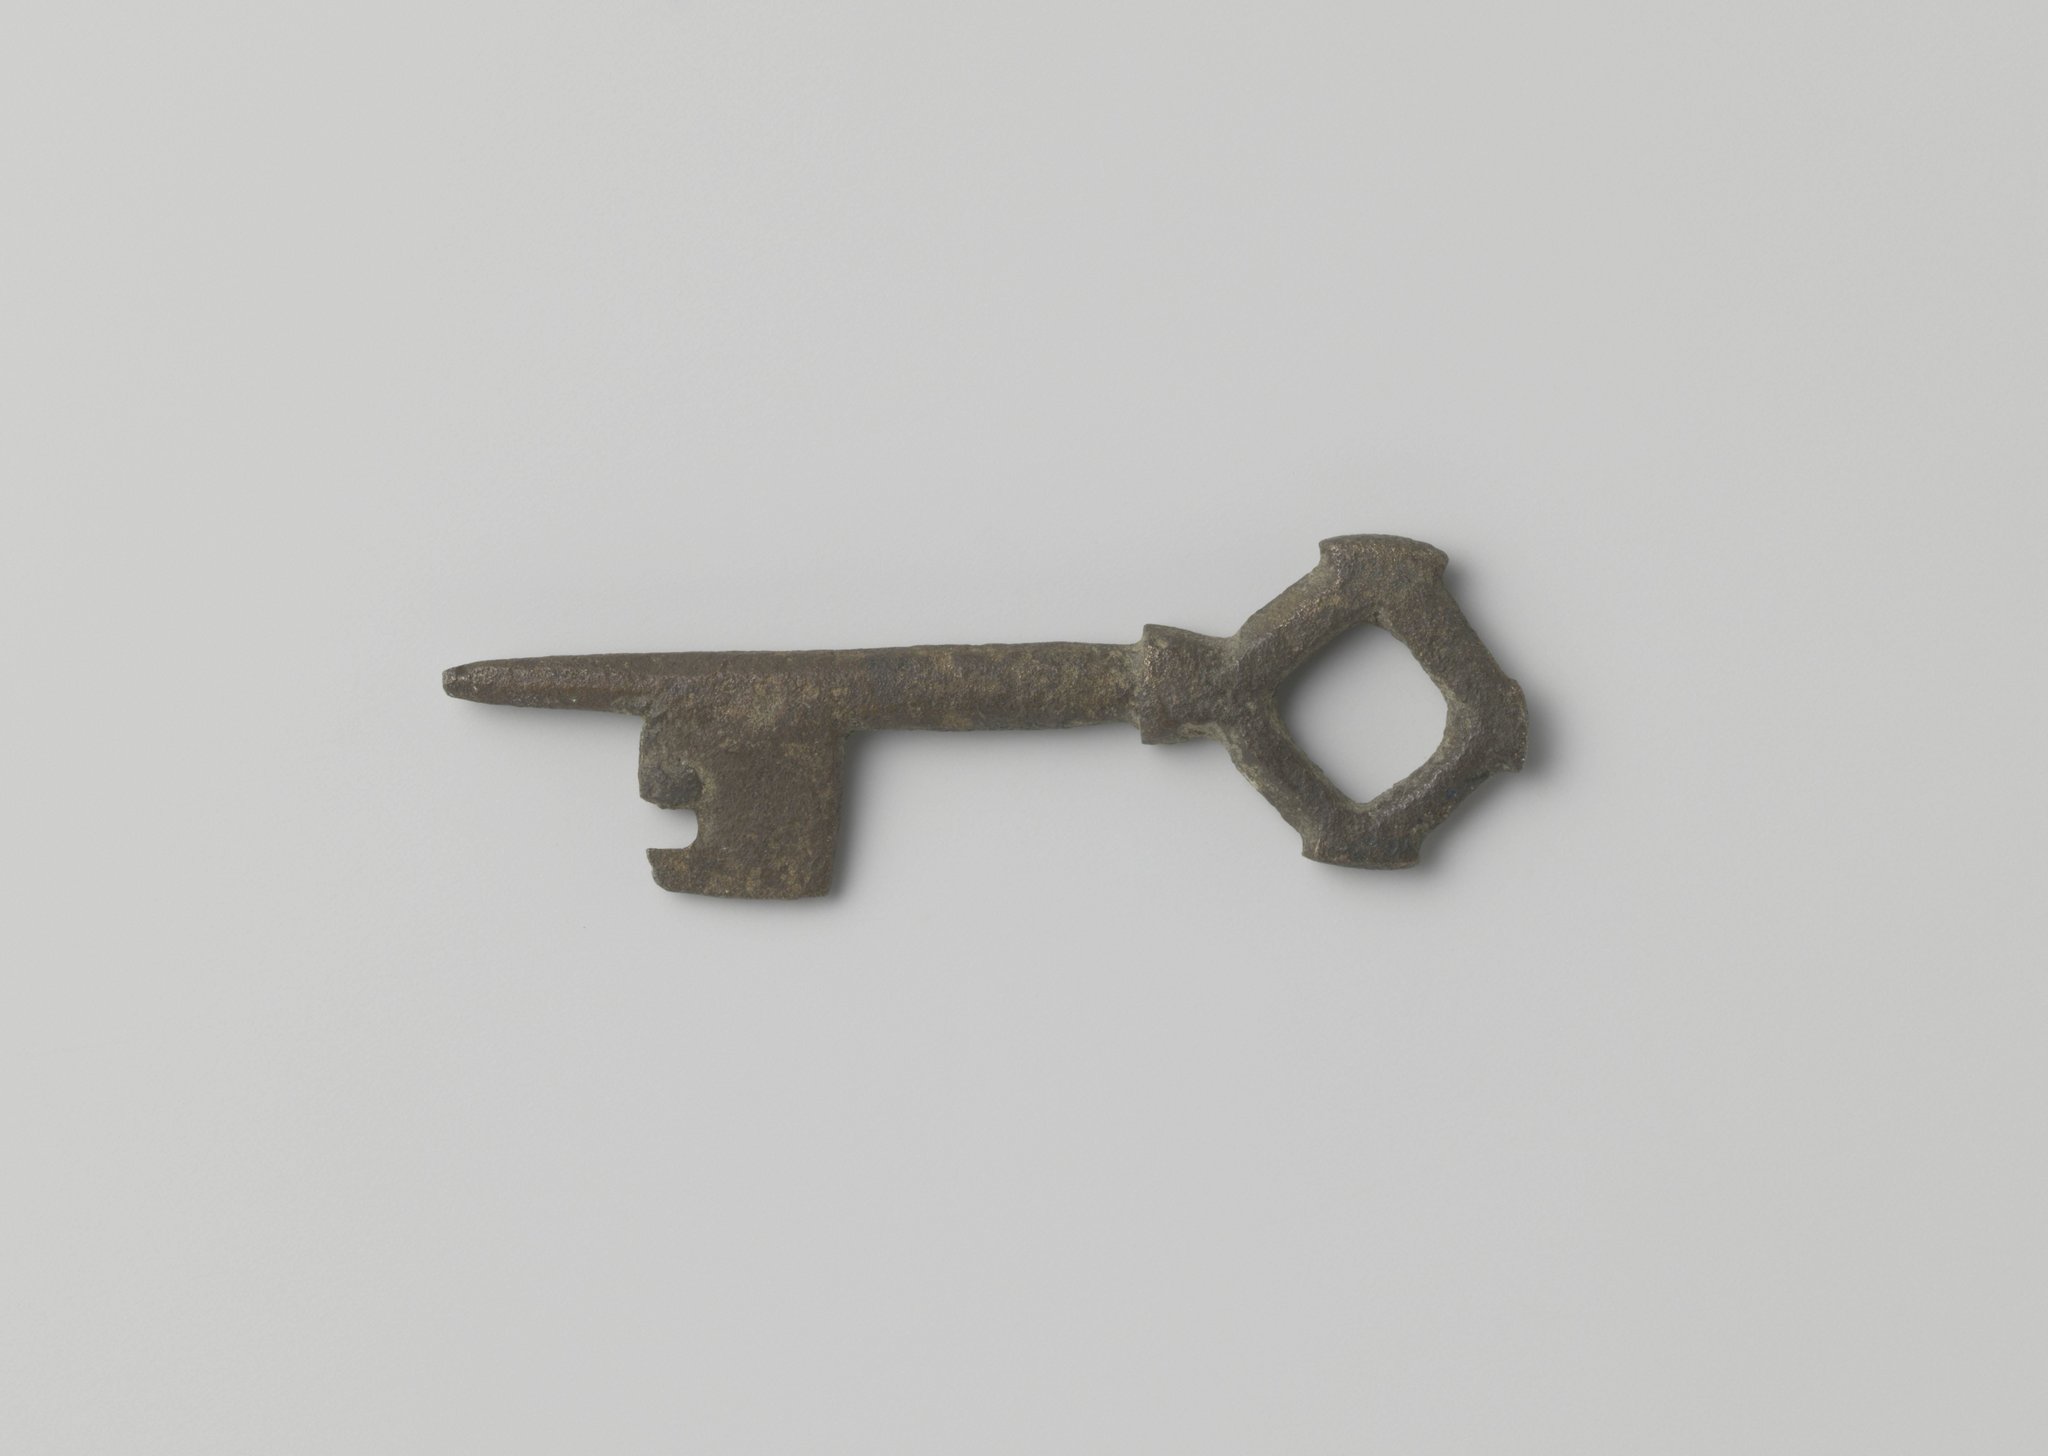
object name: socket wrench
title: Dopsleutel van brons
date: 1300-1400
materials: bronze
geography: france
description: Bronzen dopsleutel, ruitvormige ring, pen uitlopende in spitse punt, baard van onderen ingesneden.